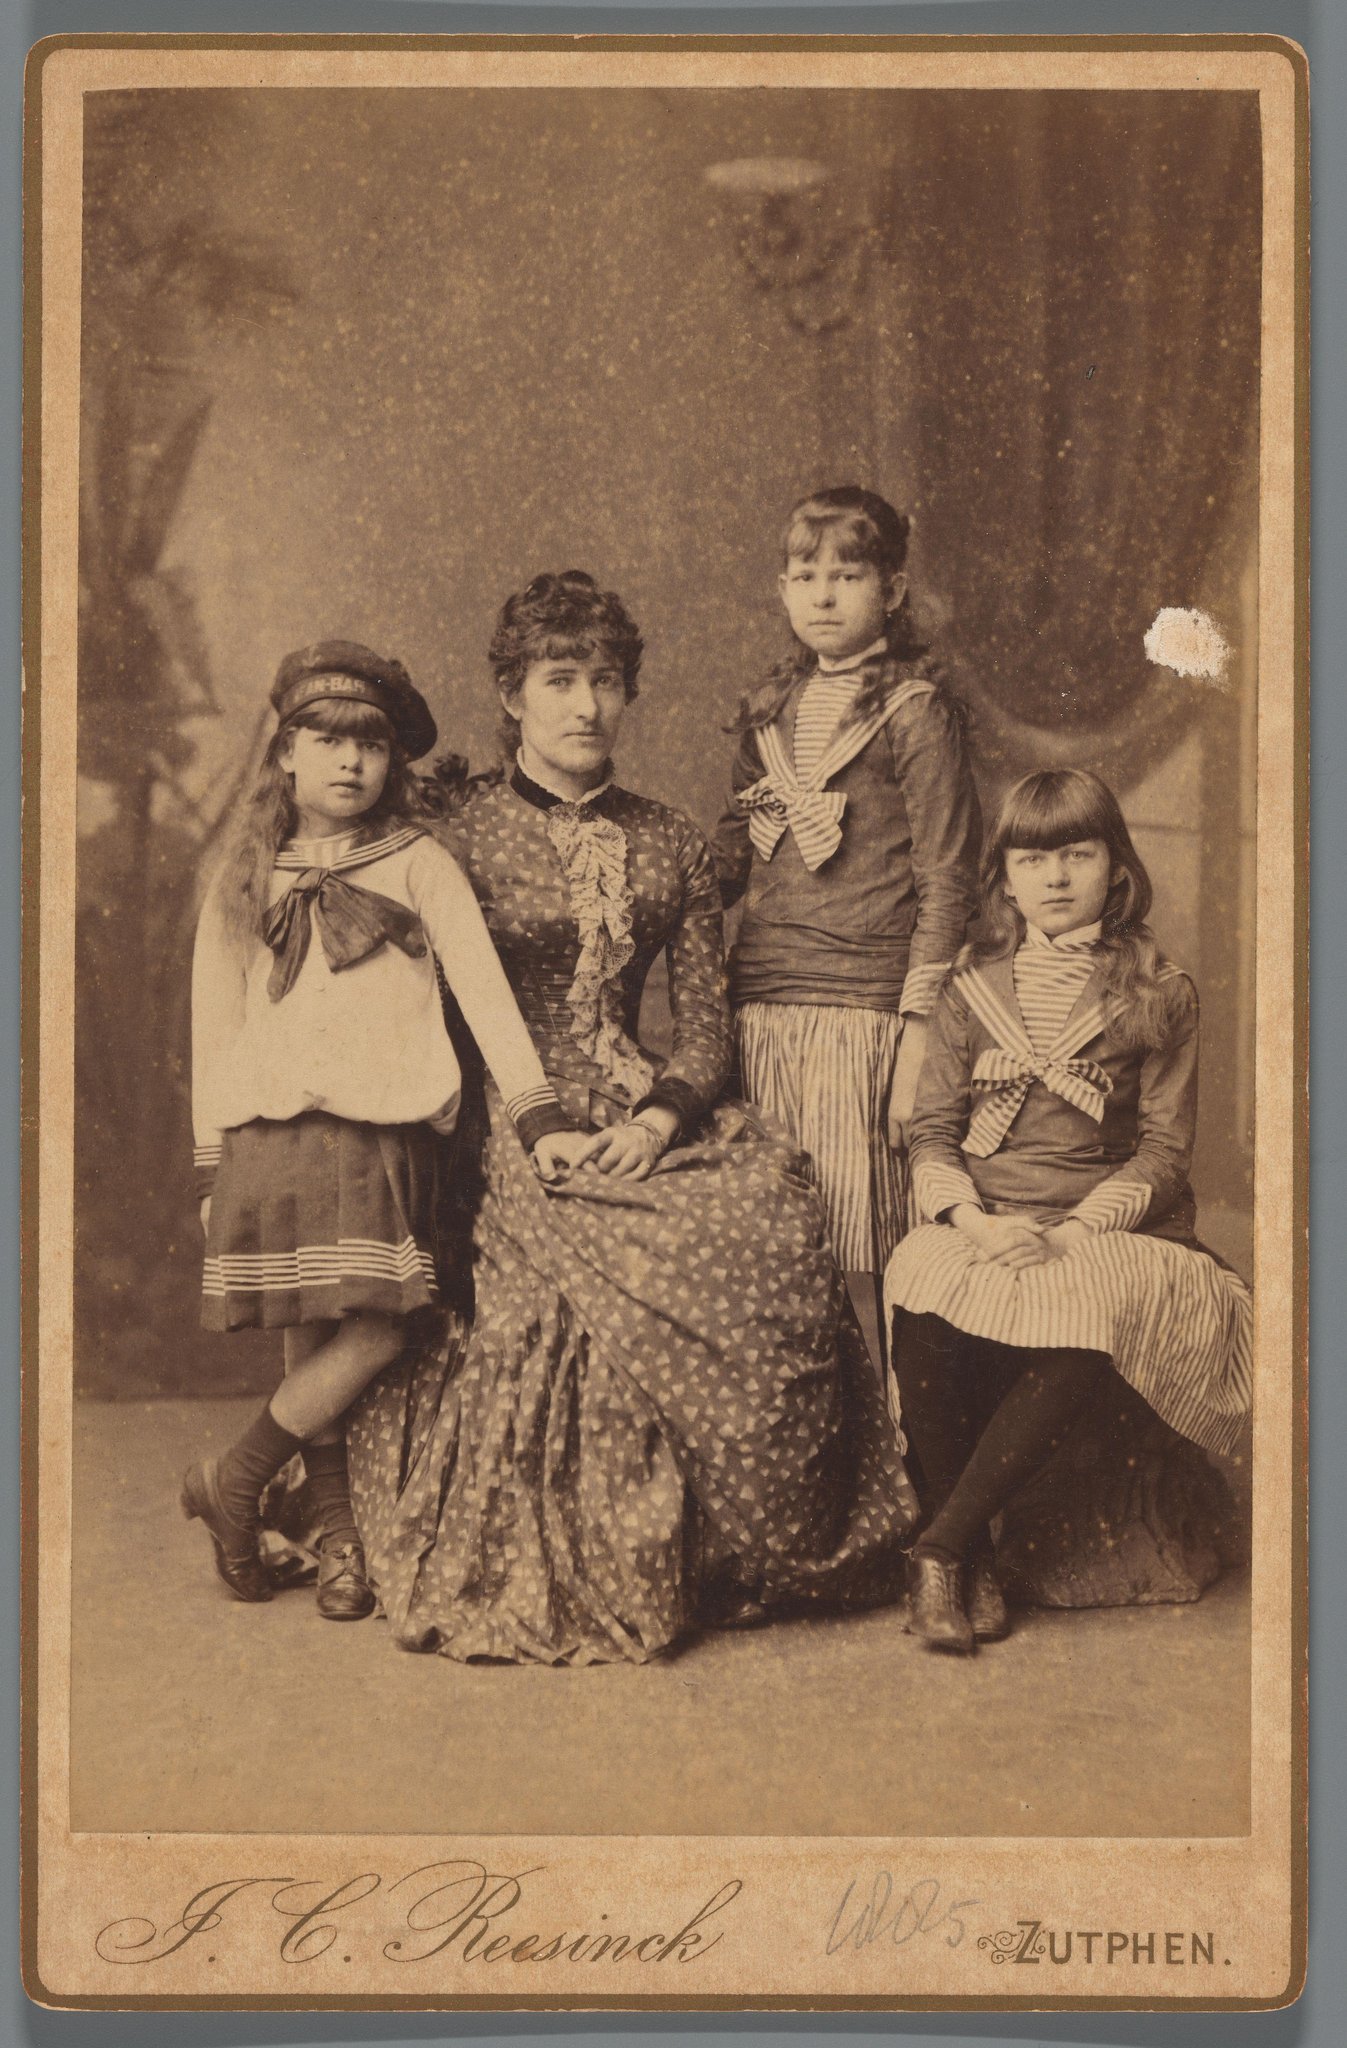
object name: cabinet photograph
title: Studioportret van Francine Schas met drie dochters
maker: johan christiaan reesinck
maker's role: fotograaf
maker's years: 1838-1922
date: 1809-1885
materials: cardboard, photographic support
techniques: albumen print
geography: zutphen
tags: francina schas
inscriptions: name, inscription: ‘A. v.d. Berg oud 11½ j. / L. v.d. " " 9½ j. / J. " " " " 7½ j. / ... / oud ??? / September 85’